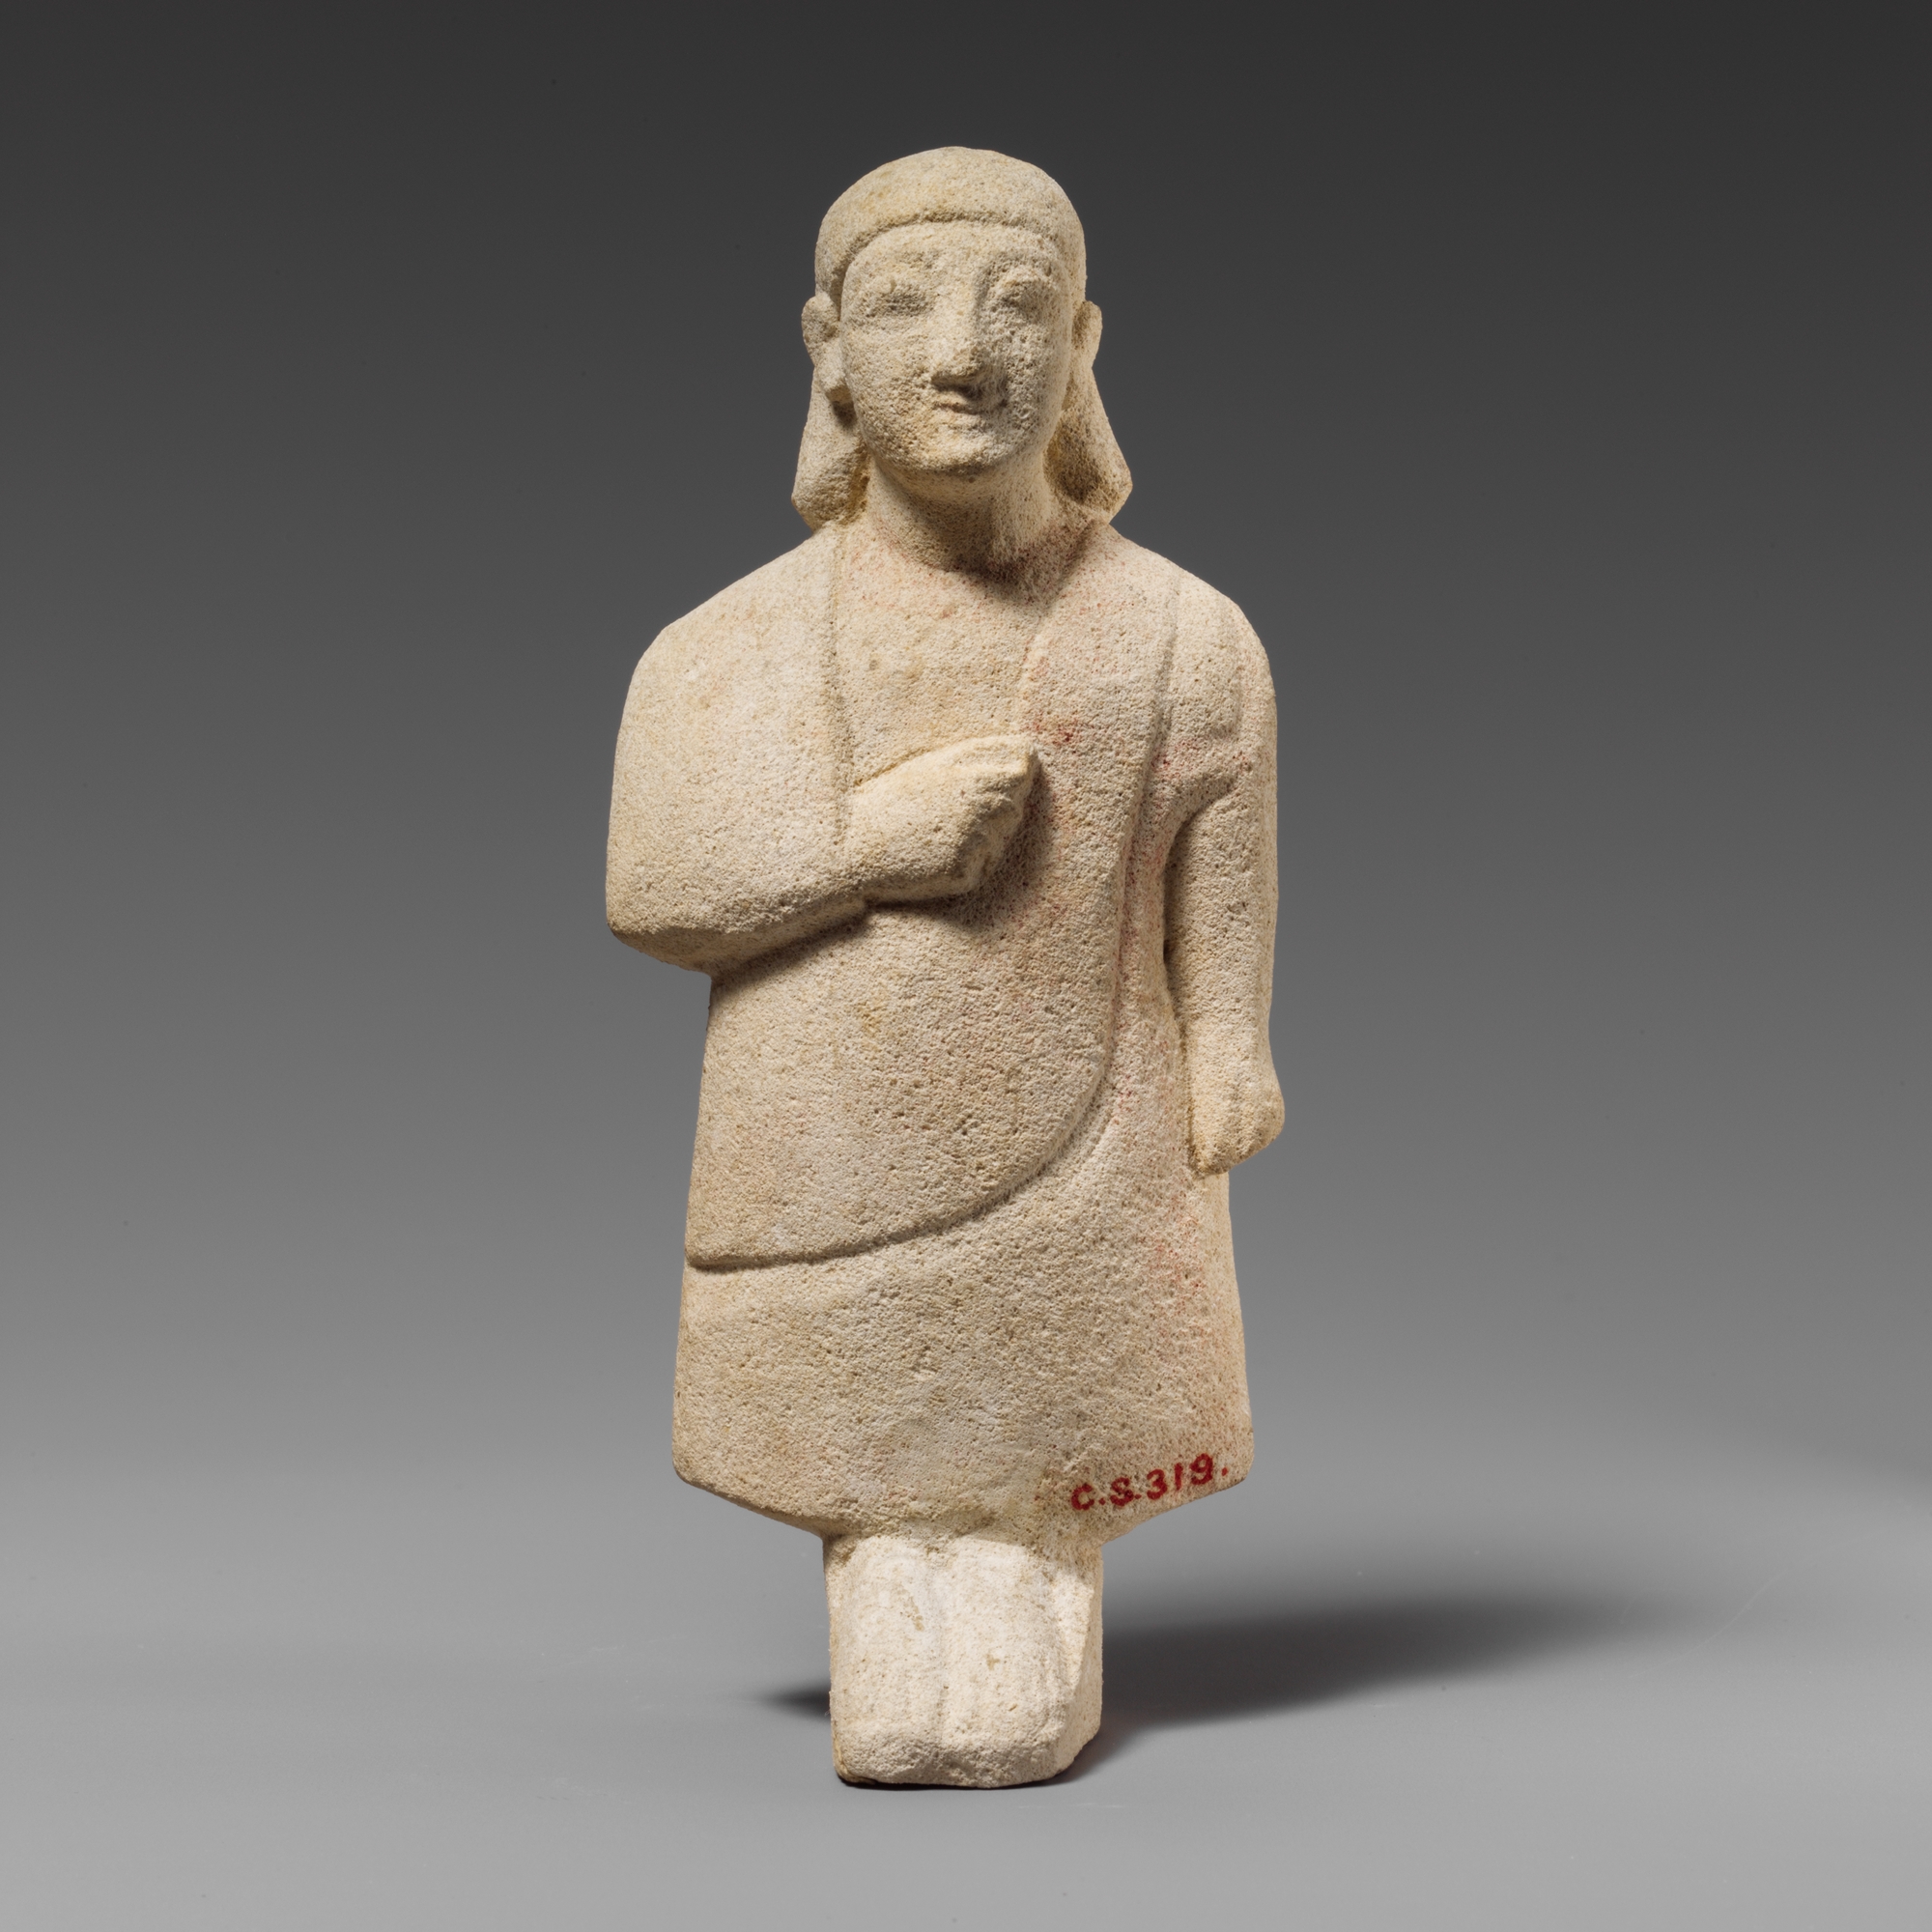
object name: statuette of a votary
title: Limestone statuette of a male votary with a plain headdress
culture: cypriot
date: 567-535 BCE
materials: limestone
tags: men